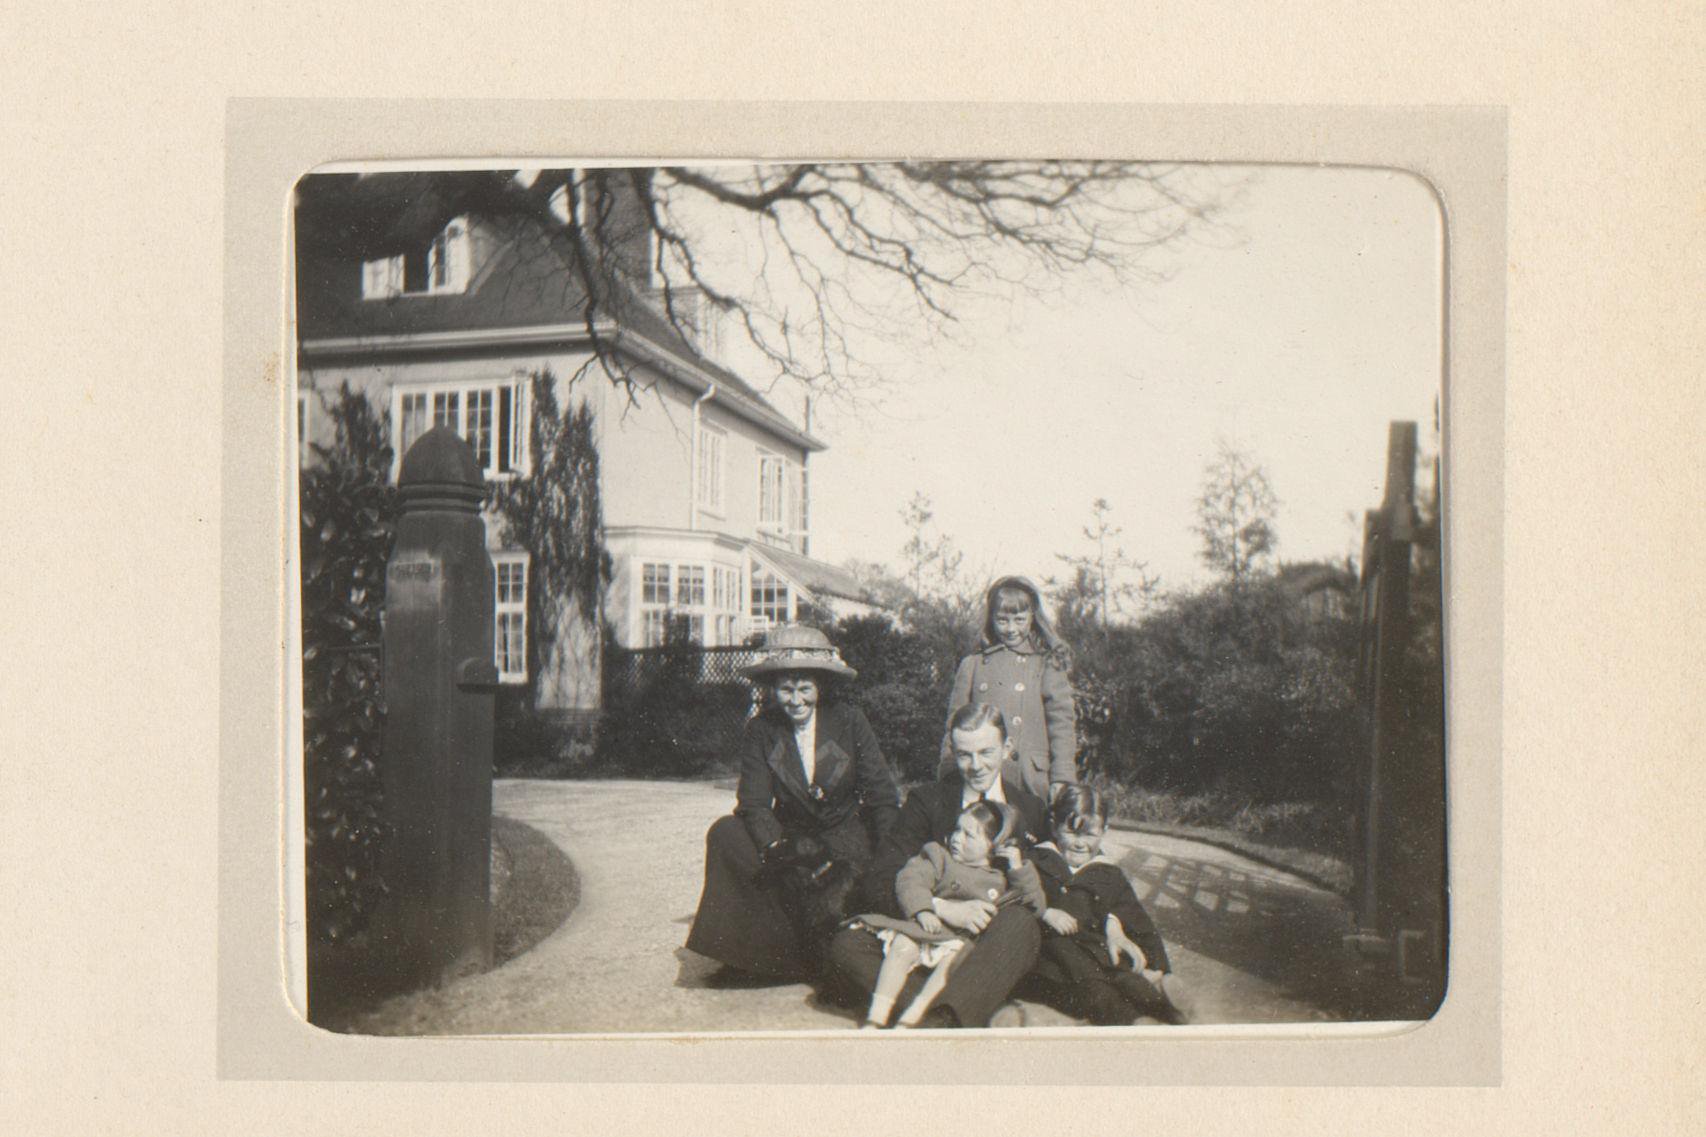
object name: photograph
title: Portret van een man en vrouw en drie kinderen op een oprit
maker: liesbeth overhoff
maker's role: fotograaf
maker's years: 1895-1969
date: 1912-1913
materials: paper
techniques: gelatin silver print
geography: london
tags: family group, especially parents with their child(ren), historical persons, garden approach, garden drive